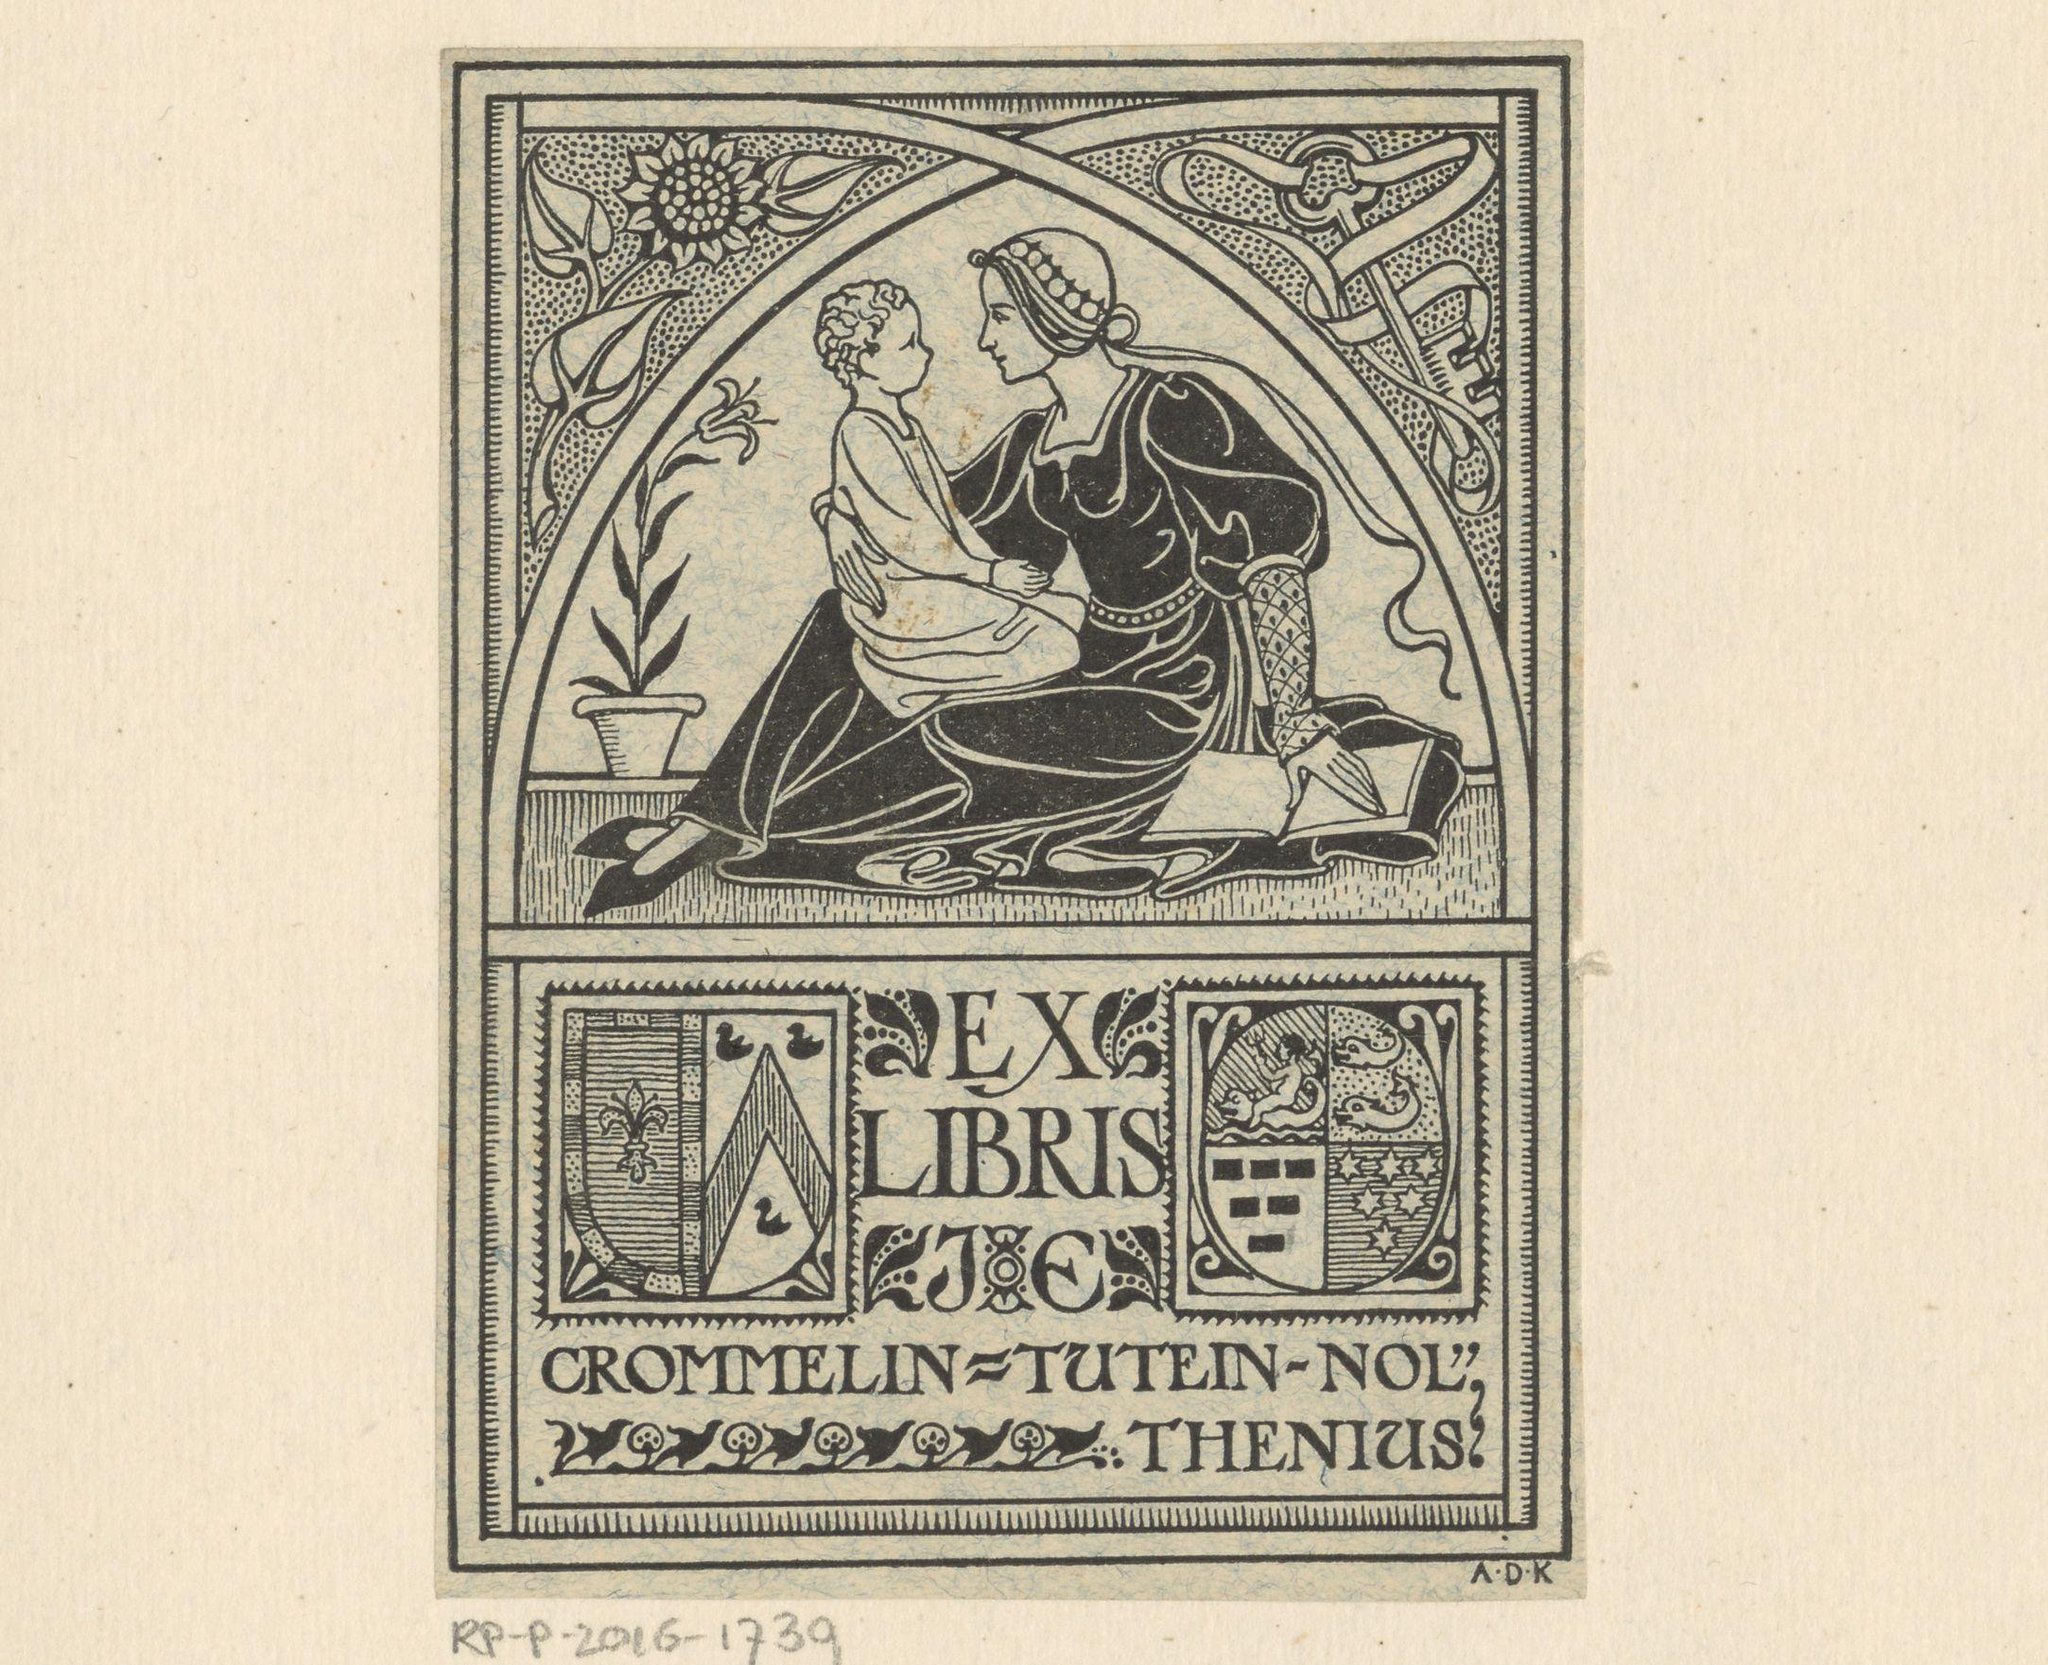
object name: bookplate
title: Ex libris van J.E. Crommelin-Tutein Nolthenius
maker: antoon derkinderen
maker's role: draughtsman, painter, print maker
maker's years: 1859-1925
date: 1893-1902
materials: paper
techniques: printing block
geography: netherlands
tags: amsterdam, mother and baby or young child, armorial bearing, heraldry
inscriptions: inscription: ‘44.2528’